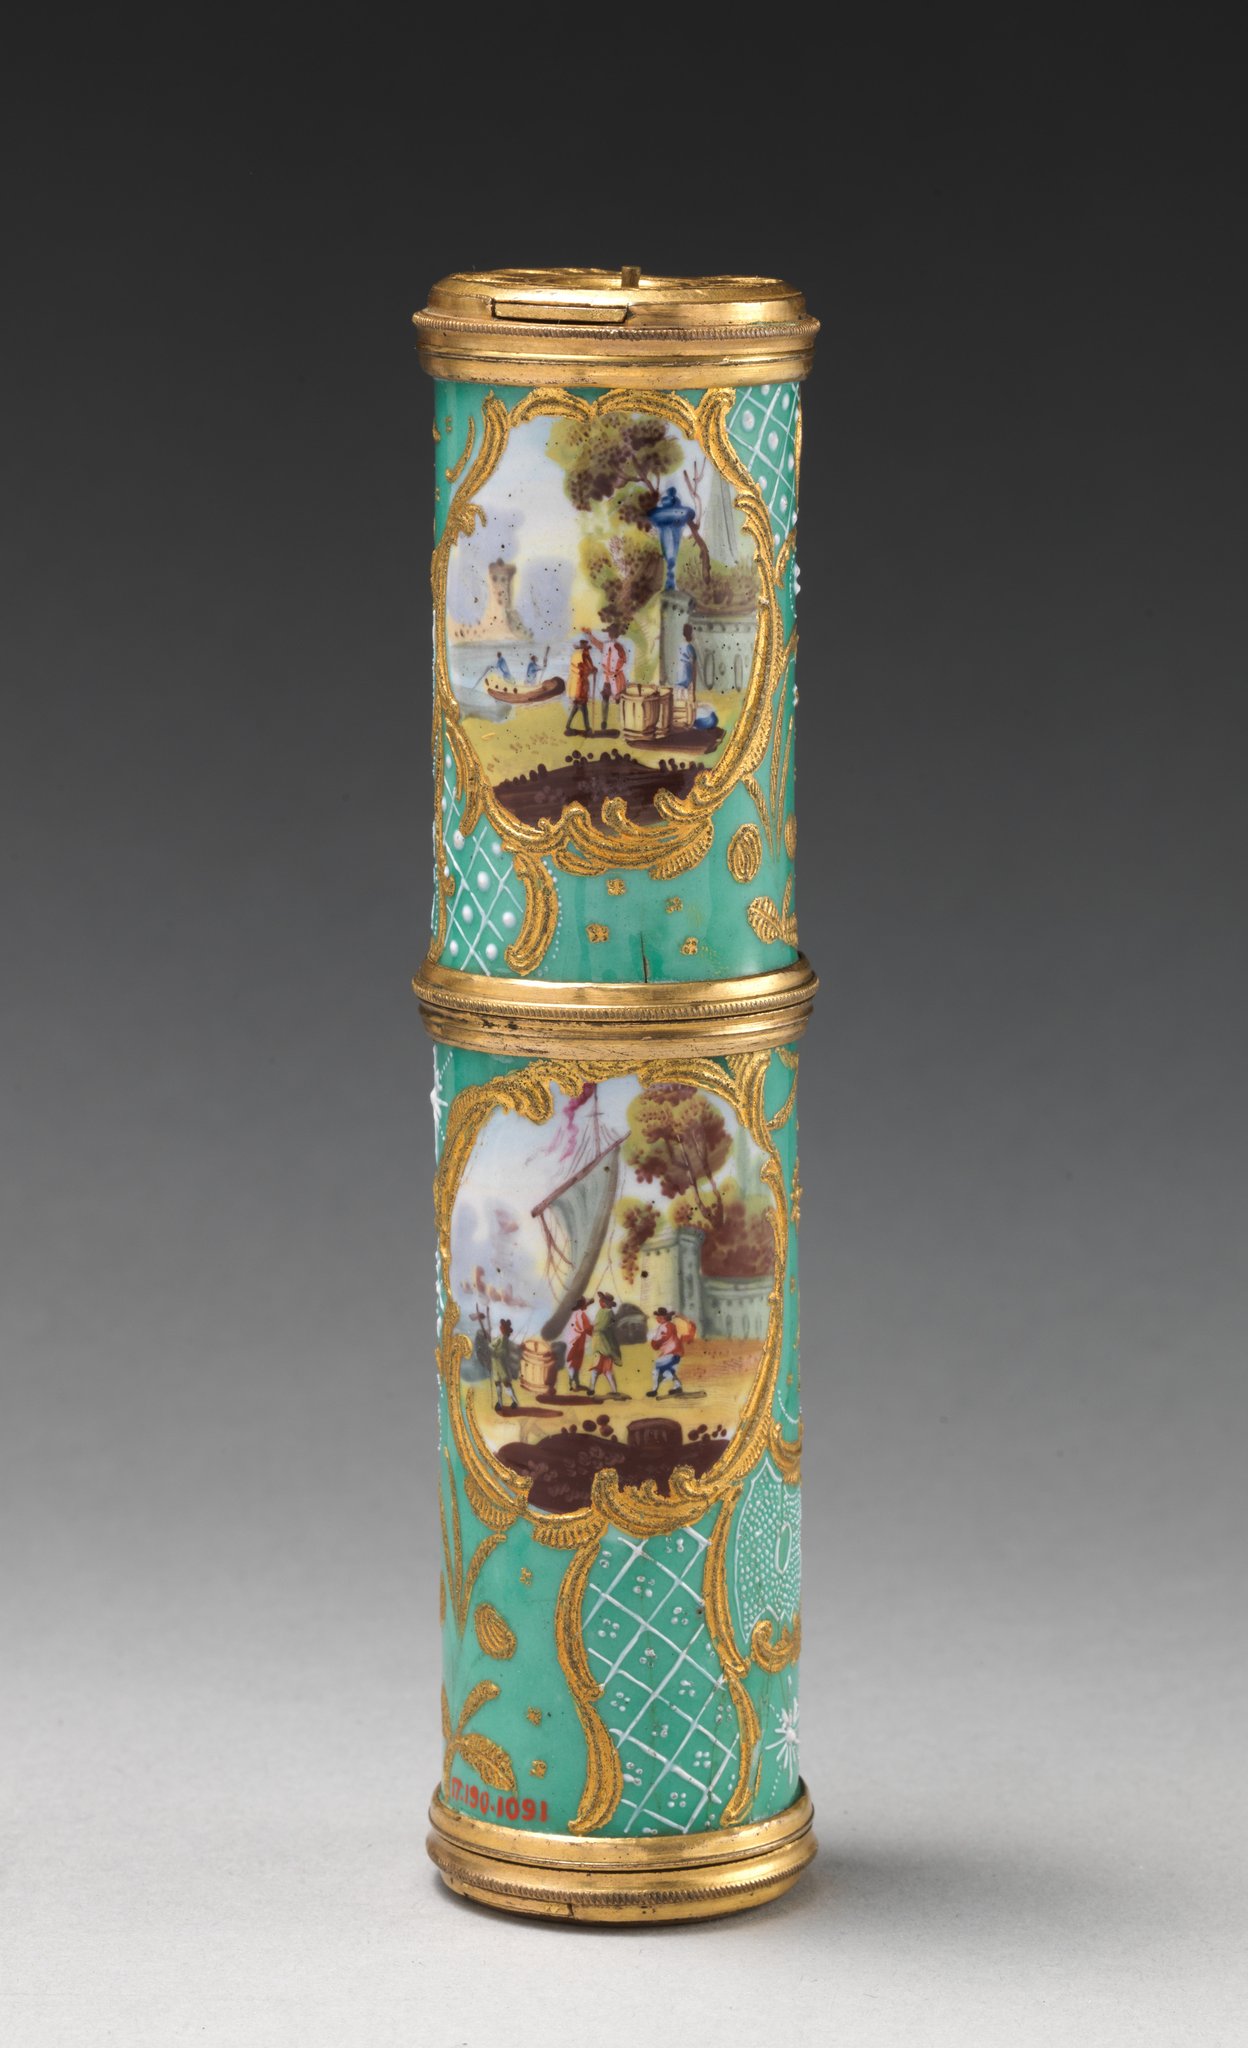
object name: nécessaire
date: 1765-1770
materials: copper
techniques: enamel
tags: human figures,animals